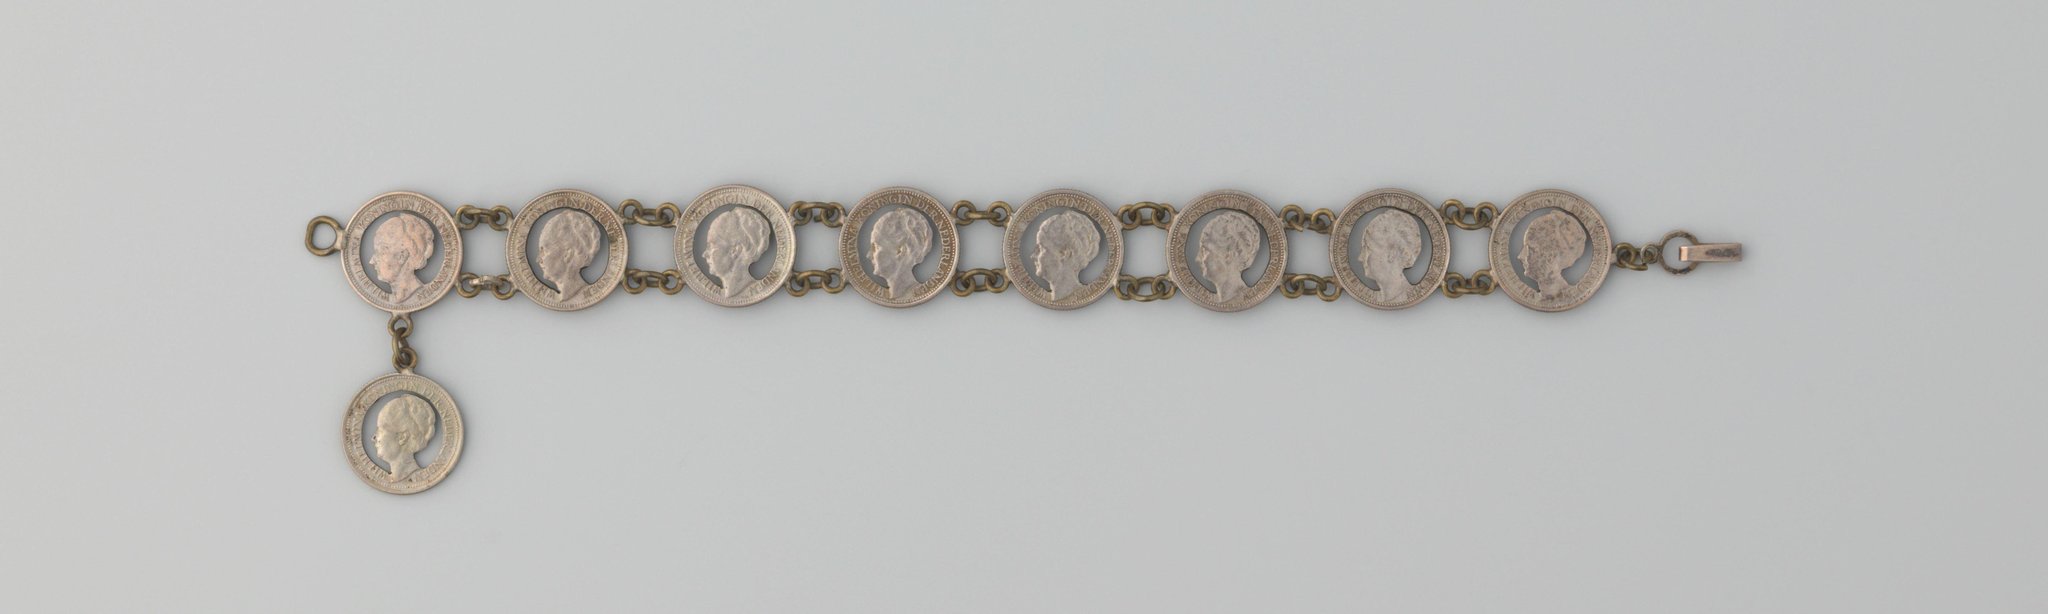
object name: bracelet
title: Zilveren armband van negen gezaagde Nederlandse dubbeltjes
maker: Anonymous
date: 1940-1950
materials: silver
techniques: sawing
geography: netherlands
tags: the hague, print maker, wilhelmina of the netherlands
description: Zilveren armband van negen gezaagde Nederlandse dubbeltjes door onedele ogen geschakeld en voorzien van een haaksluiting. Het negende dubbeltje hangt aan een dubbeltje waaraan de de sluiting is bevestigd. De armband is niet gekeurd.